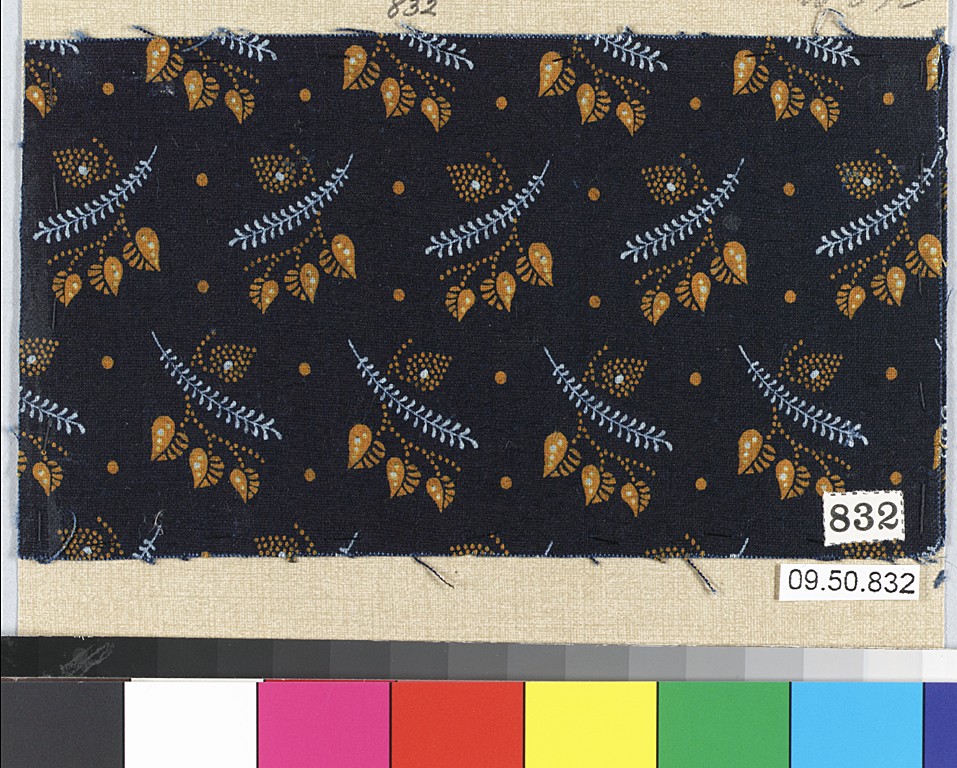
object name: piece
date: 1801-1900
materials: cotton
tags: leaves